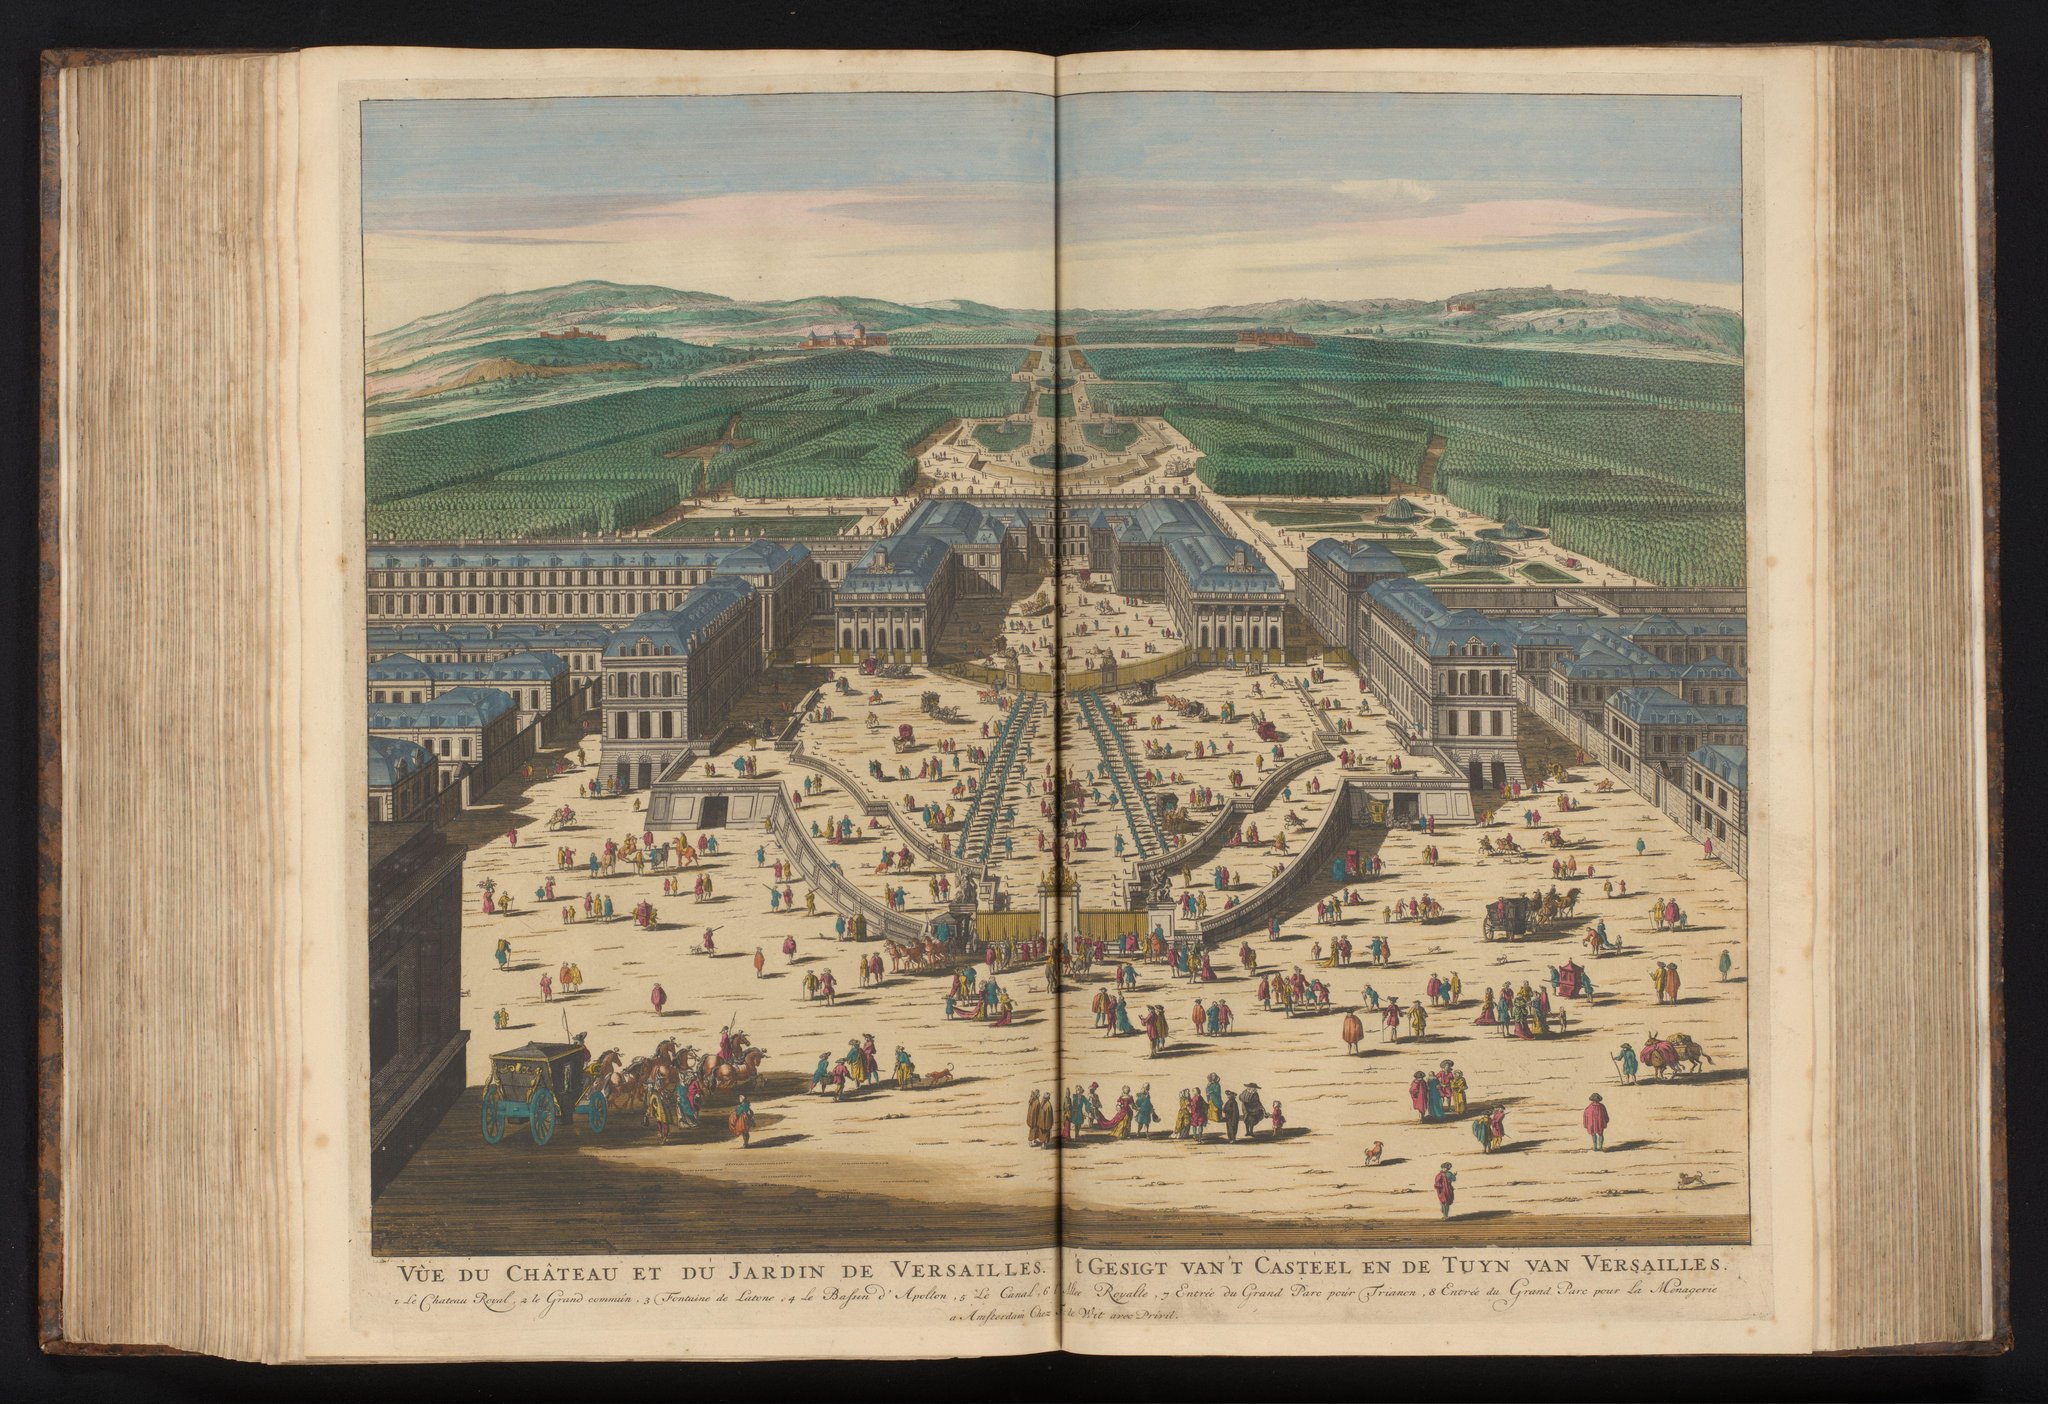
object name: print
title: 't Gesigt van't Casteel en de Tuyn van Versailles / Vûe du Château et du Jardin de Versailles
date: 1648-1712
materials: paper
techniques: engraving, etching, hand coloring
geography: northern netherlands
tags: four-wheeled, animal-drawn vehicle, e.g.: cab, carriage, coach, palace, french or architectonic garden; formal garden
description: Gezicht op het paleis en de tuinen van Versailles. Op de voorgrond vele figuren en koetsen. Prent maakt deel uit van een album.